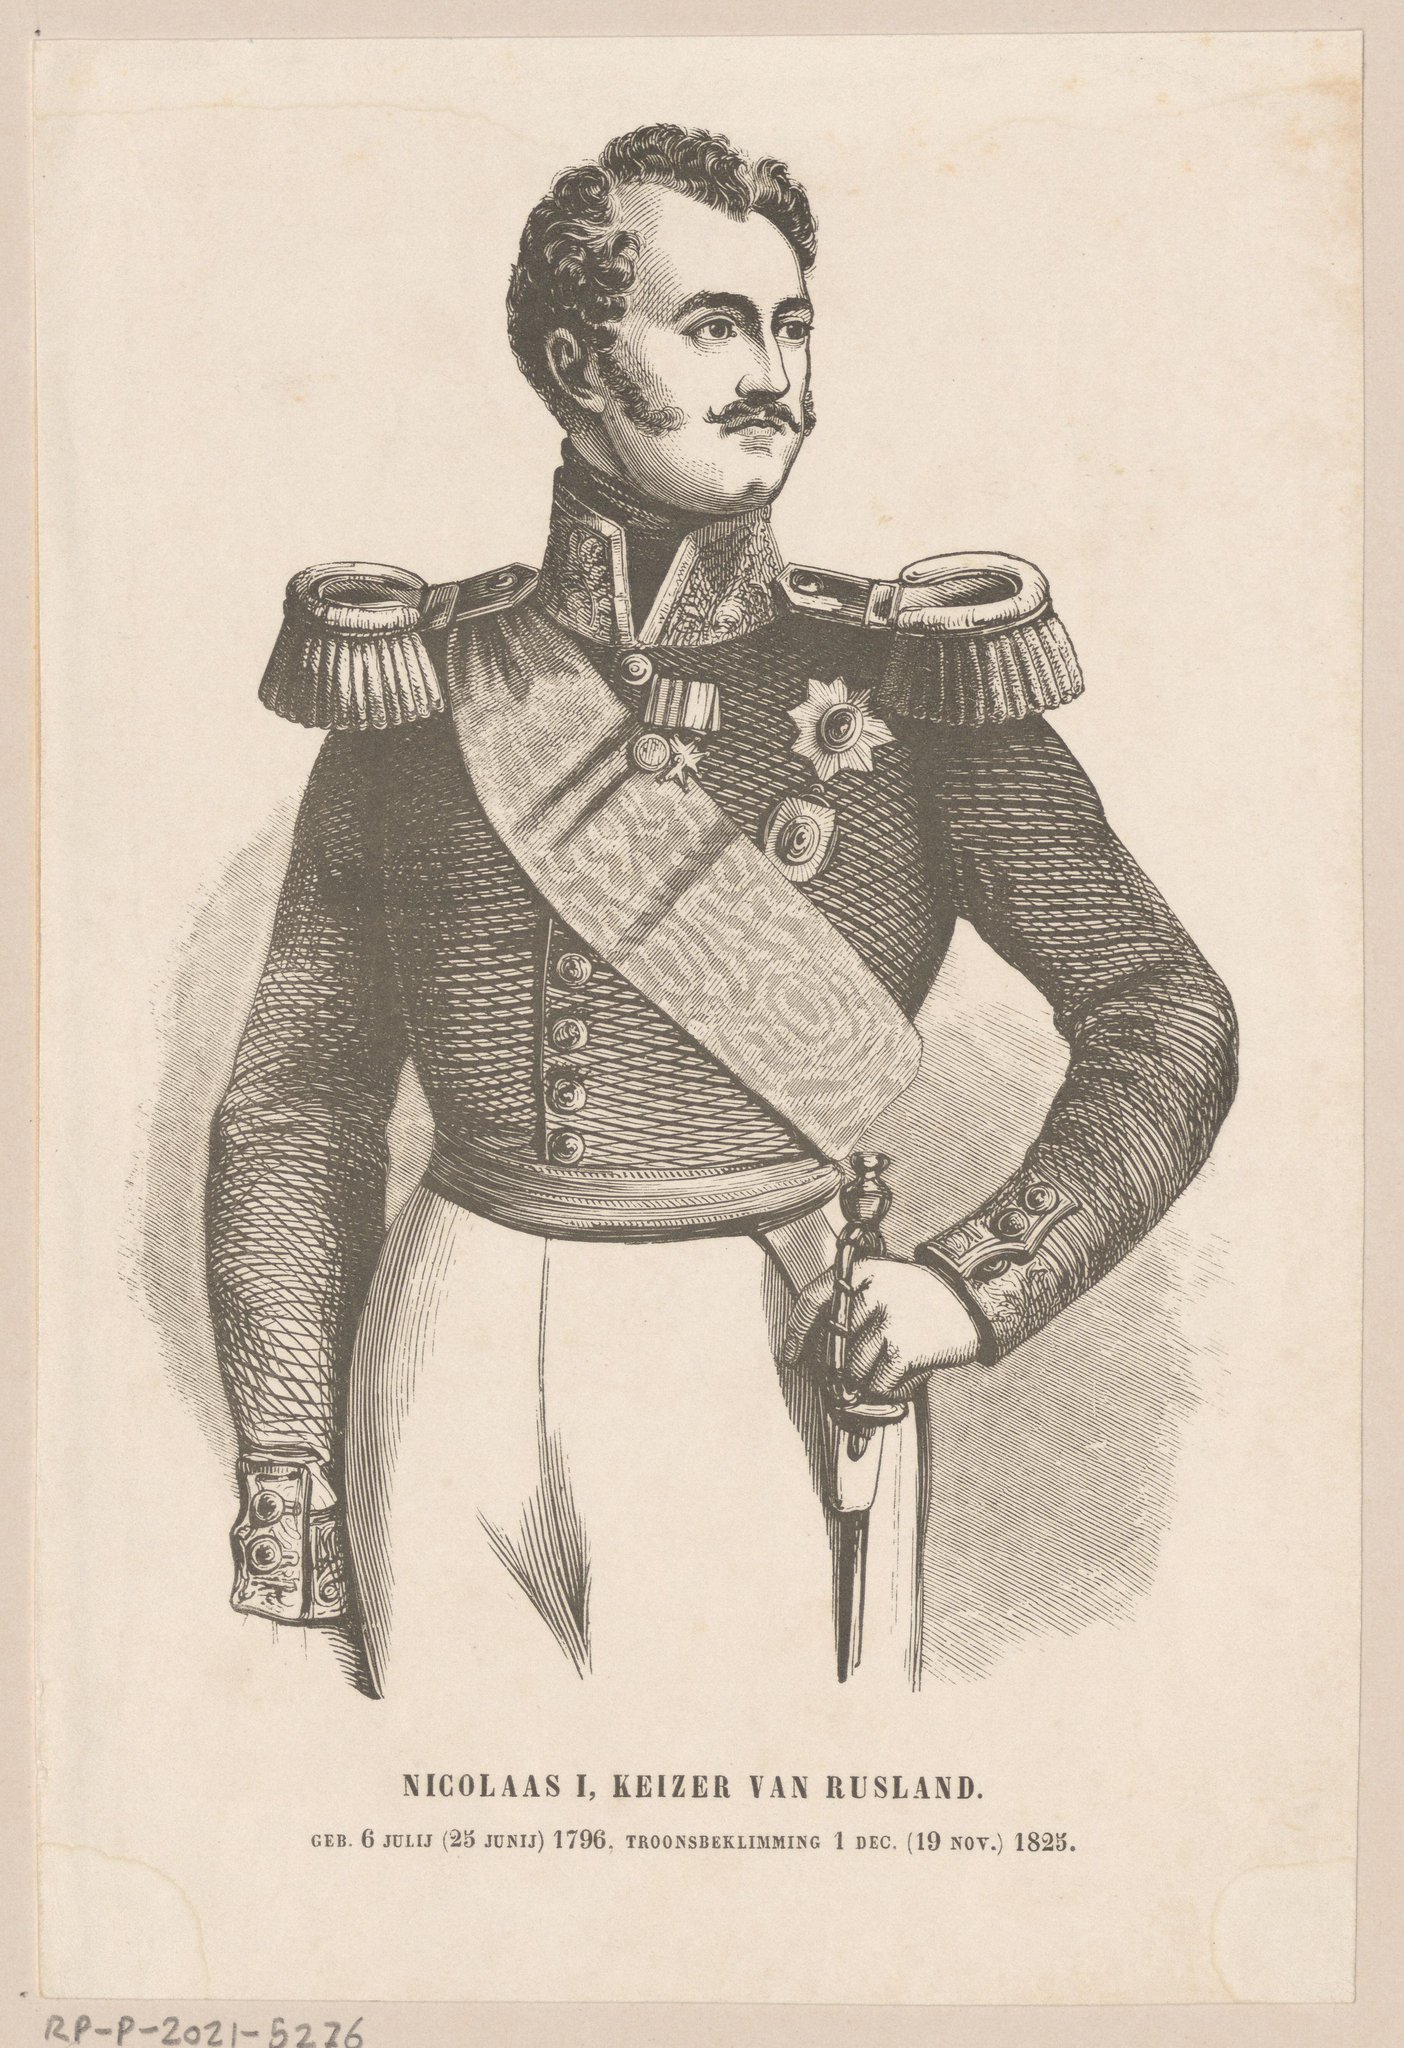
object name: print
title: Portret van Nicolaas I Pavlovitsj, tsaar van Rusland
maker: Anonymous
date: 1850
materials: paper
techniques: letterpress printing, engraving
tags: knighthood order, historical persons, emperor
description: Prent waarschijnlijk uit: De tijdspiegel. Den Haag: Koenraad Fuhri, 1850, dl. 2.